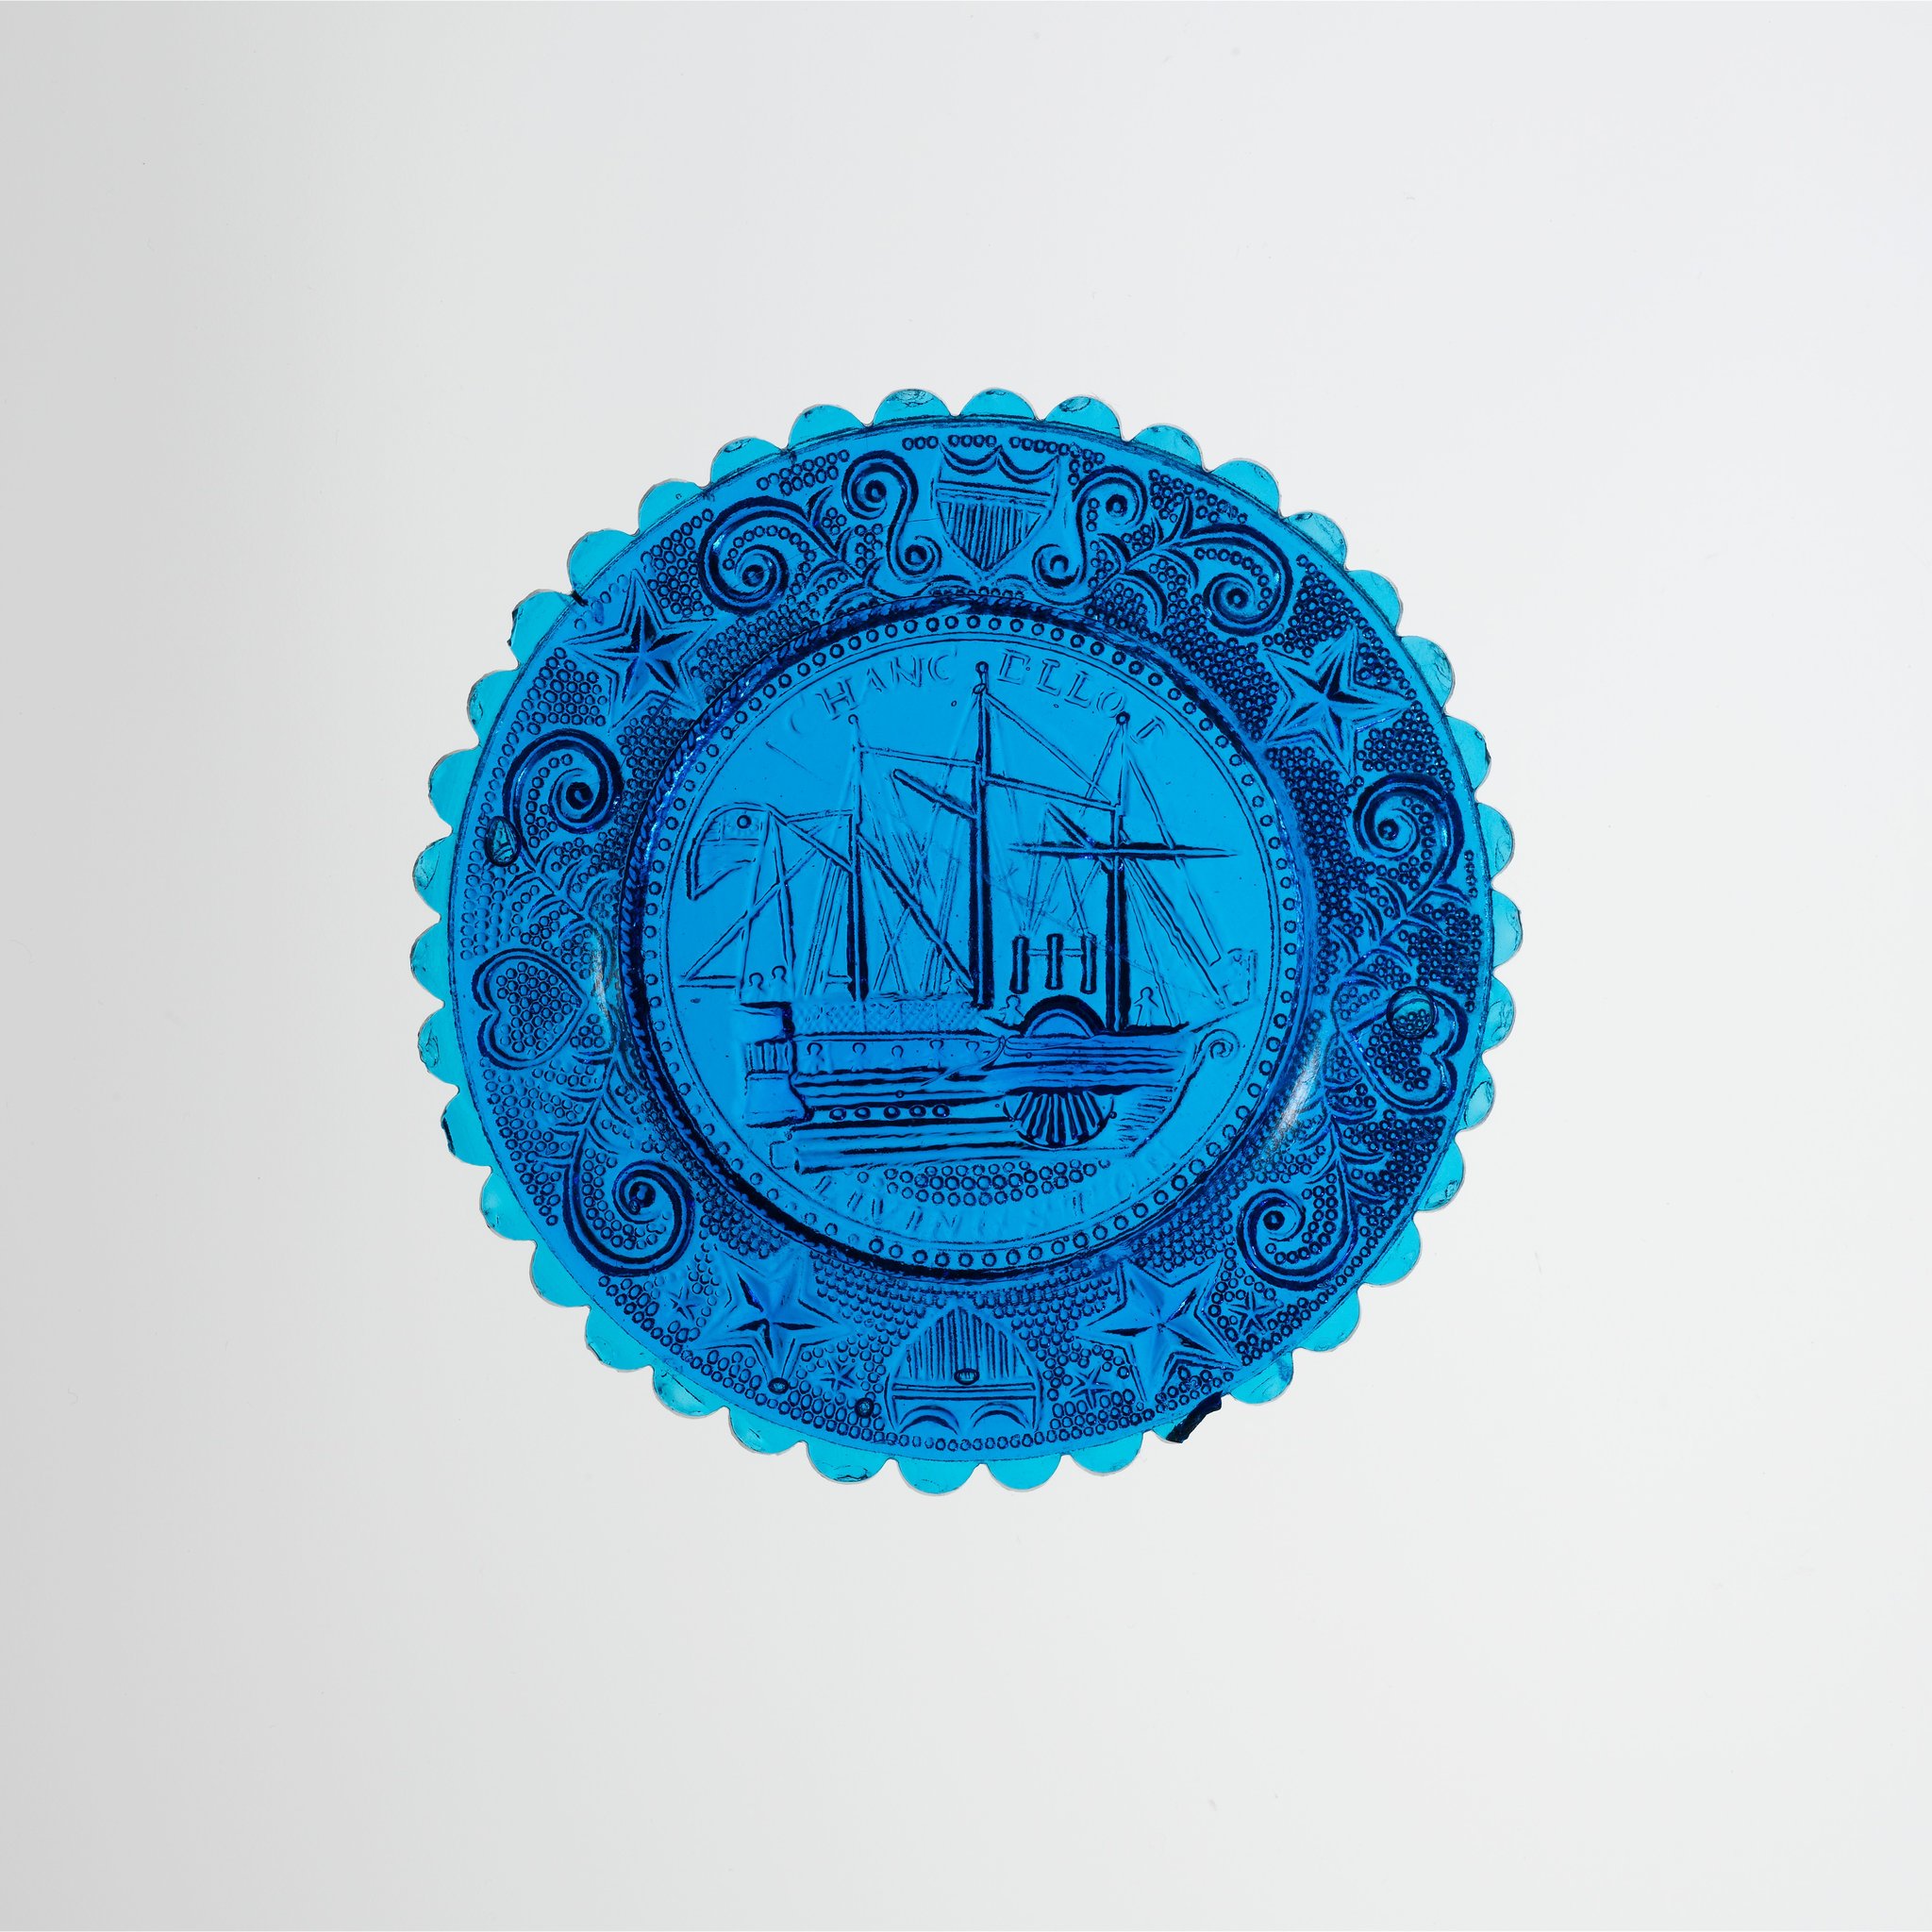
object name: cup plate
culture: american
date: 1835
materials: glass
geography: united states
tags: ships